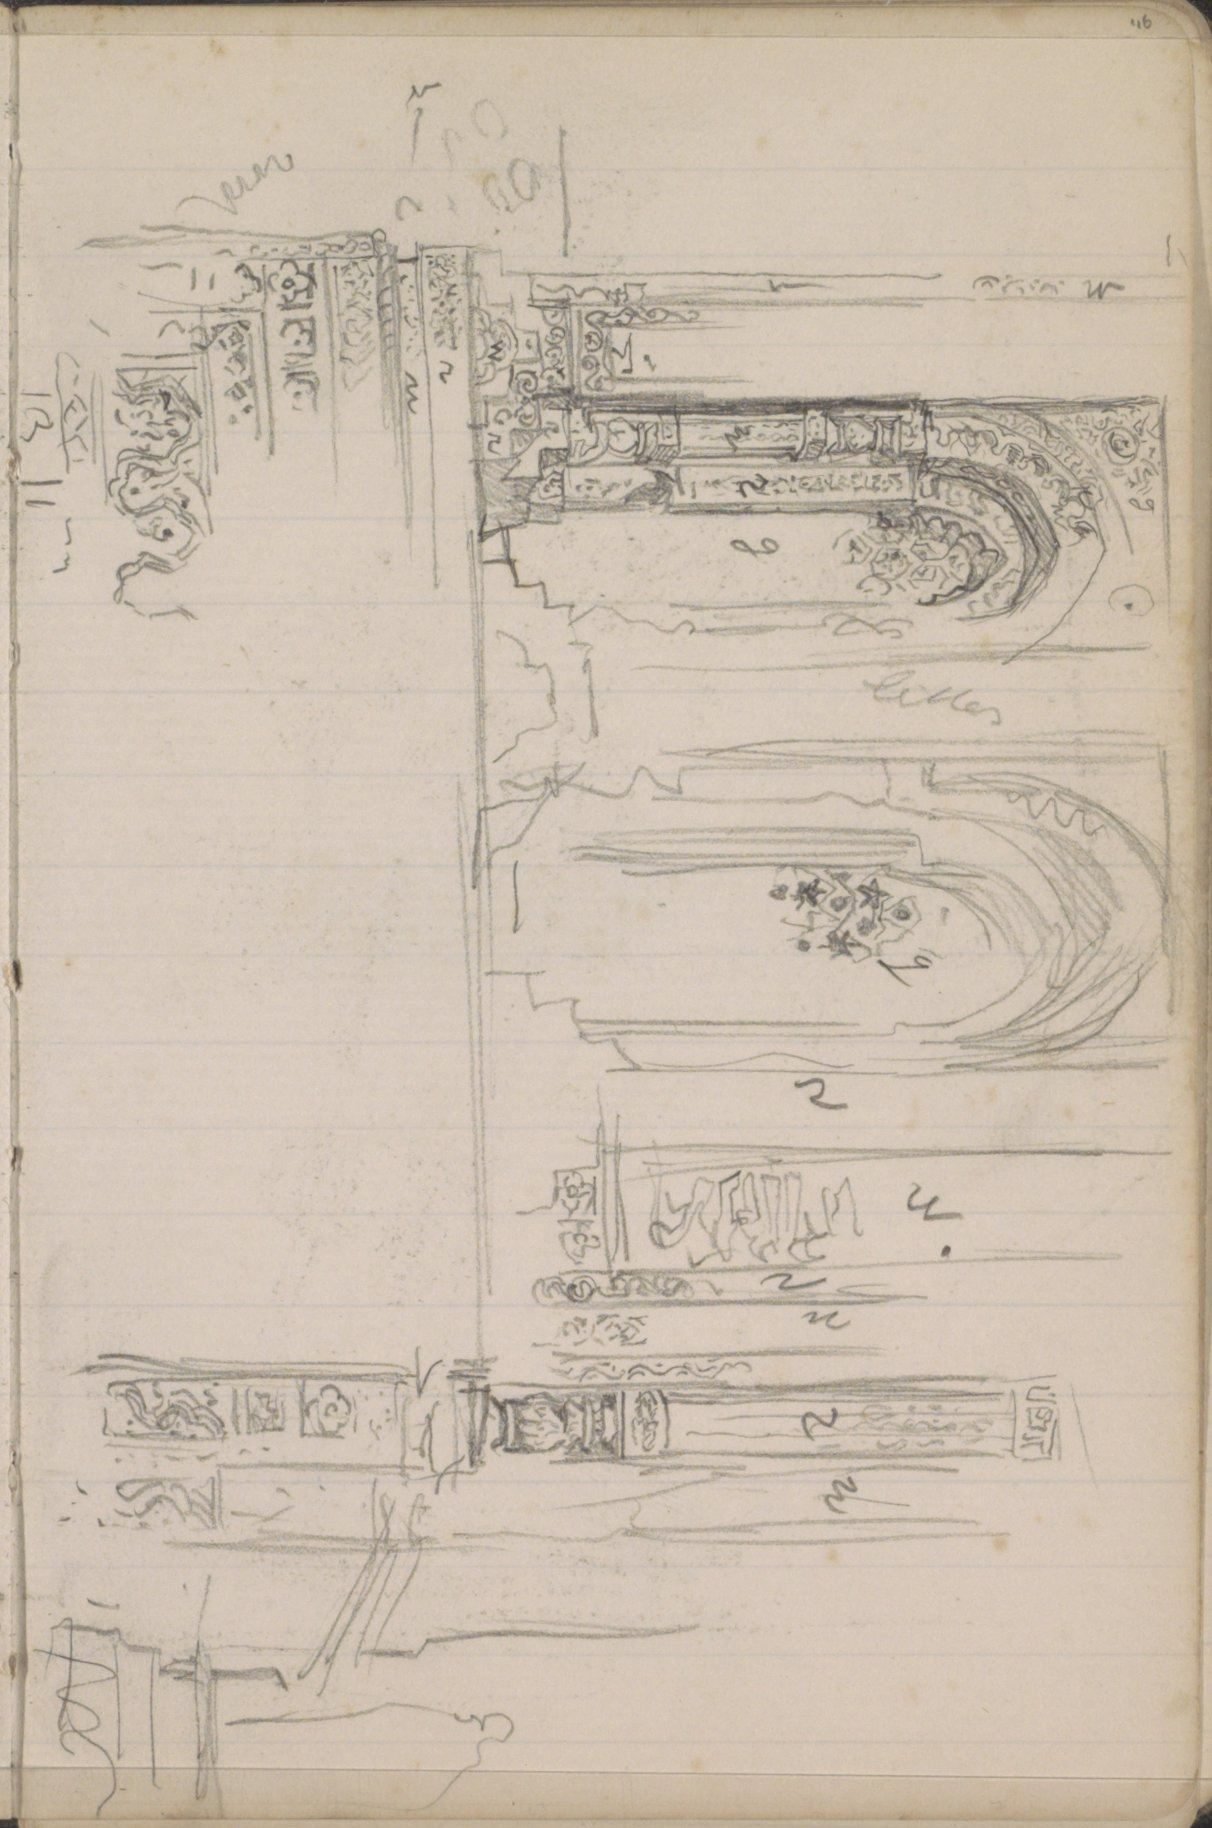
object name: sketchbook leaf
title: Twee portalen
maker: marius bauer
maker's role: draughtsman, print maker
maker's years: 1867-1932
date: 1897-1898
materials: pencil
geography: delhi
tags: column, pillar ~ architecture, arch, archivolt ~ architecture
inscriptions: kleurnotitie, handgeschreven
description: Pagina 116 uit een schetsboek met 84 bladen.